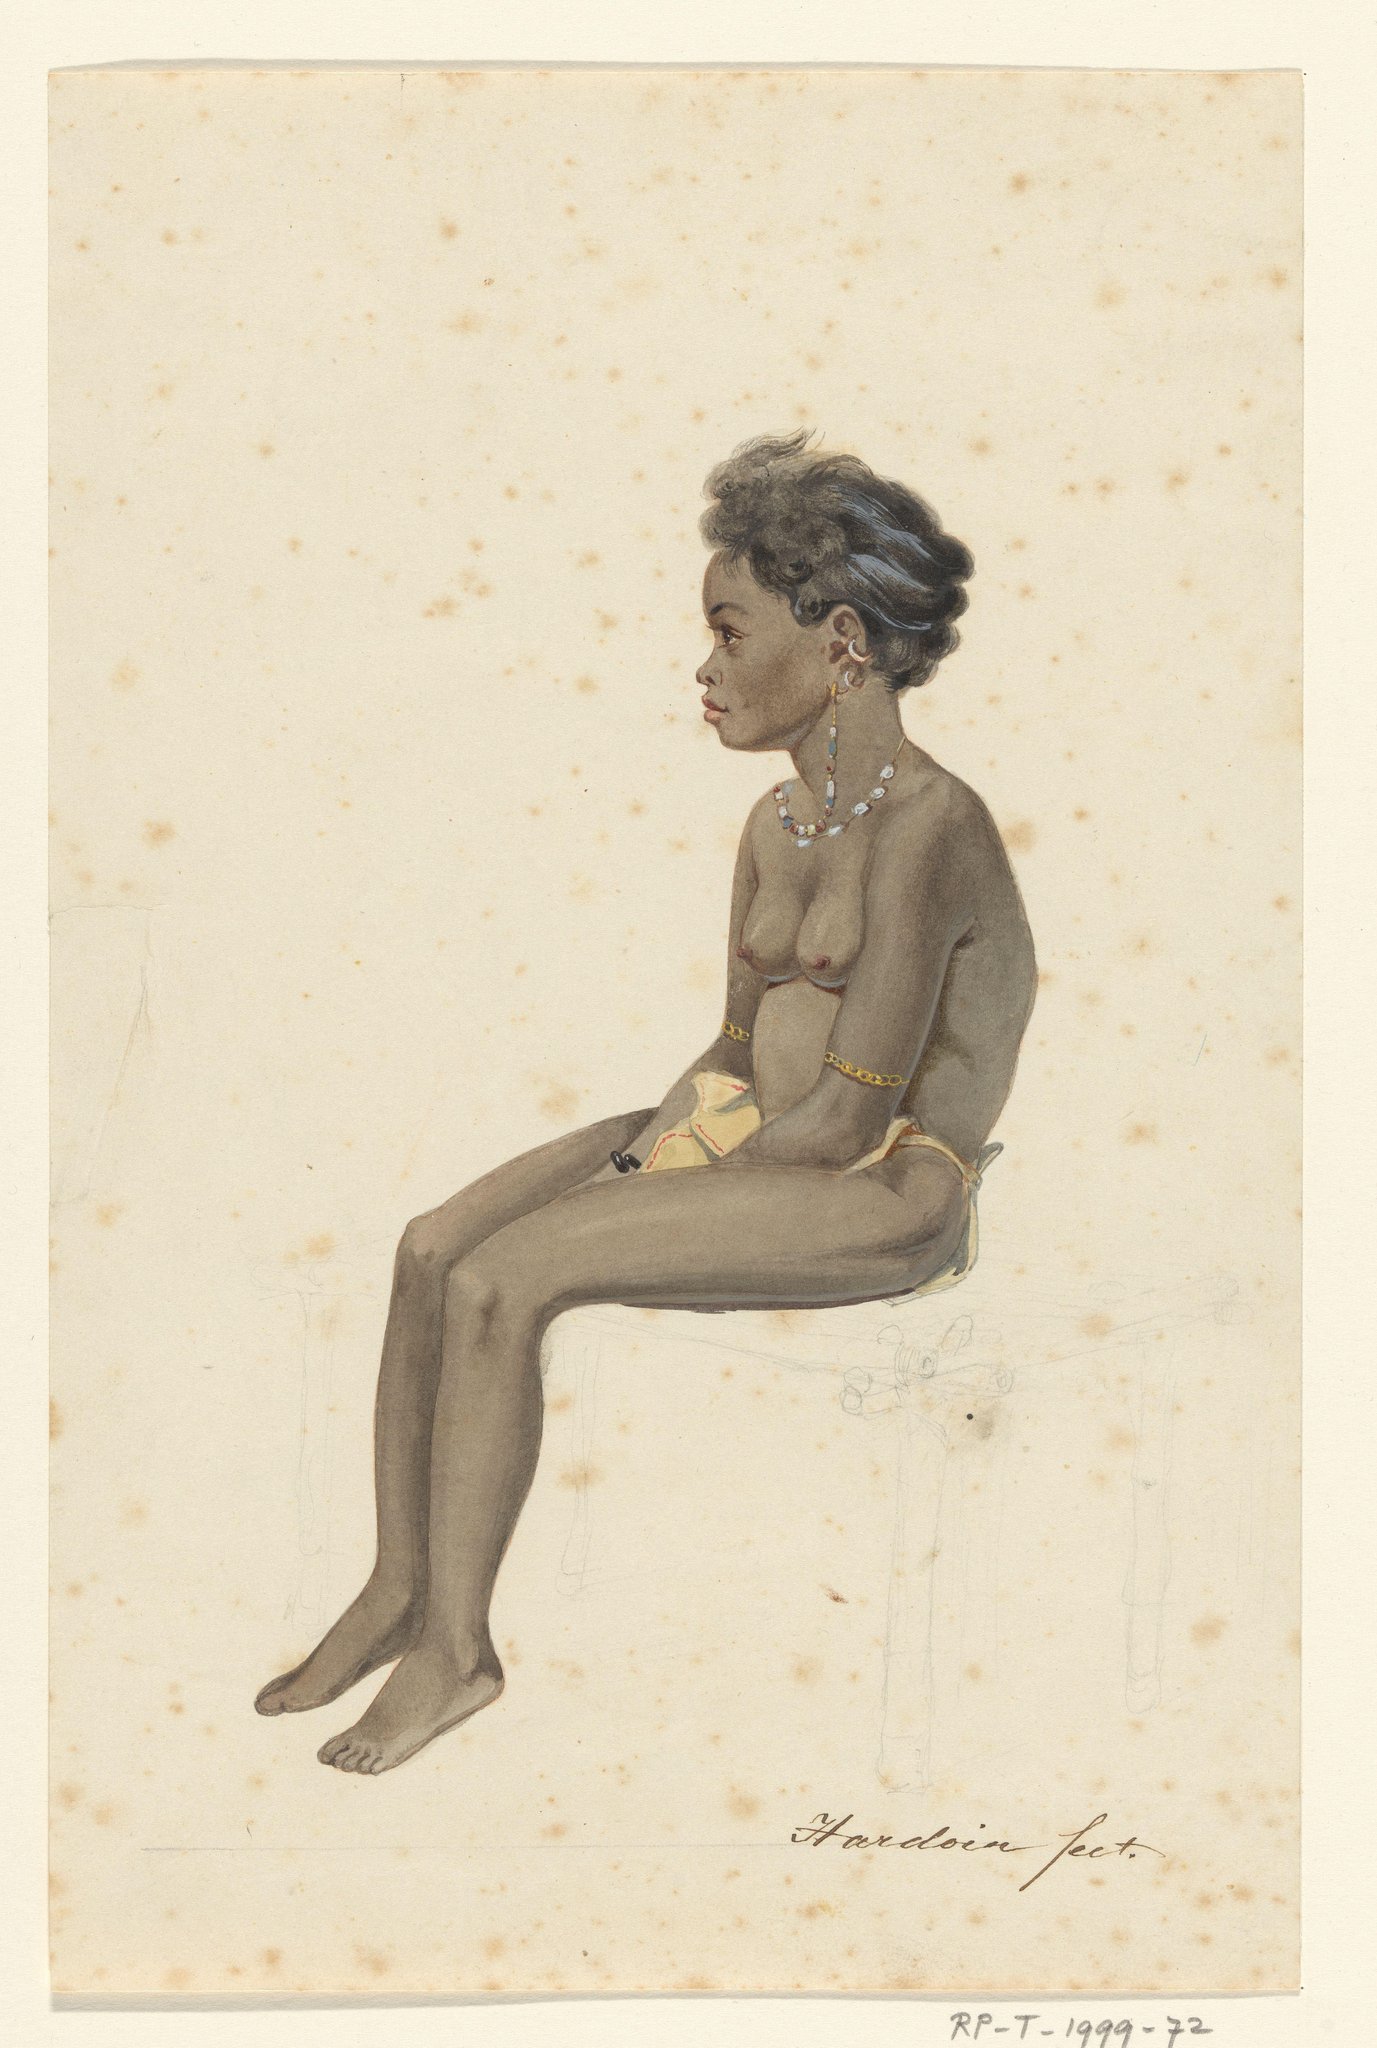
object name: watercolor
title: Portret van een dochter van de Orang Kaya (dorpshoofd) van Af(f)ara op het eiland Workai, Aru eilanden, Zuidoost-Molukken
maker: ernest alfred hardouin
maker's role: draughtsman, painter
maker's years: 1820-1853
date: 1837-1854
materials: paper, pencil, watercolor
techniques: brush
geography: aru-eilanden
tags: adolescent, young woman, maiden, sitting figure - aa - female human figure, historical persons not known by name - bb - woman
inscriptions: signature: ‘Hardoin fect.’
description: naar een tekening van A.J. Bik (C 39). A.J. Bik was beschermer van E.A. Hardouin; arikel over deze collectie in Bulletin van het Rijksmuseum 49 [2001], nr. 4, pp. 342 e.v.